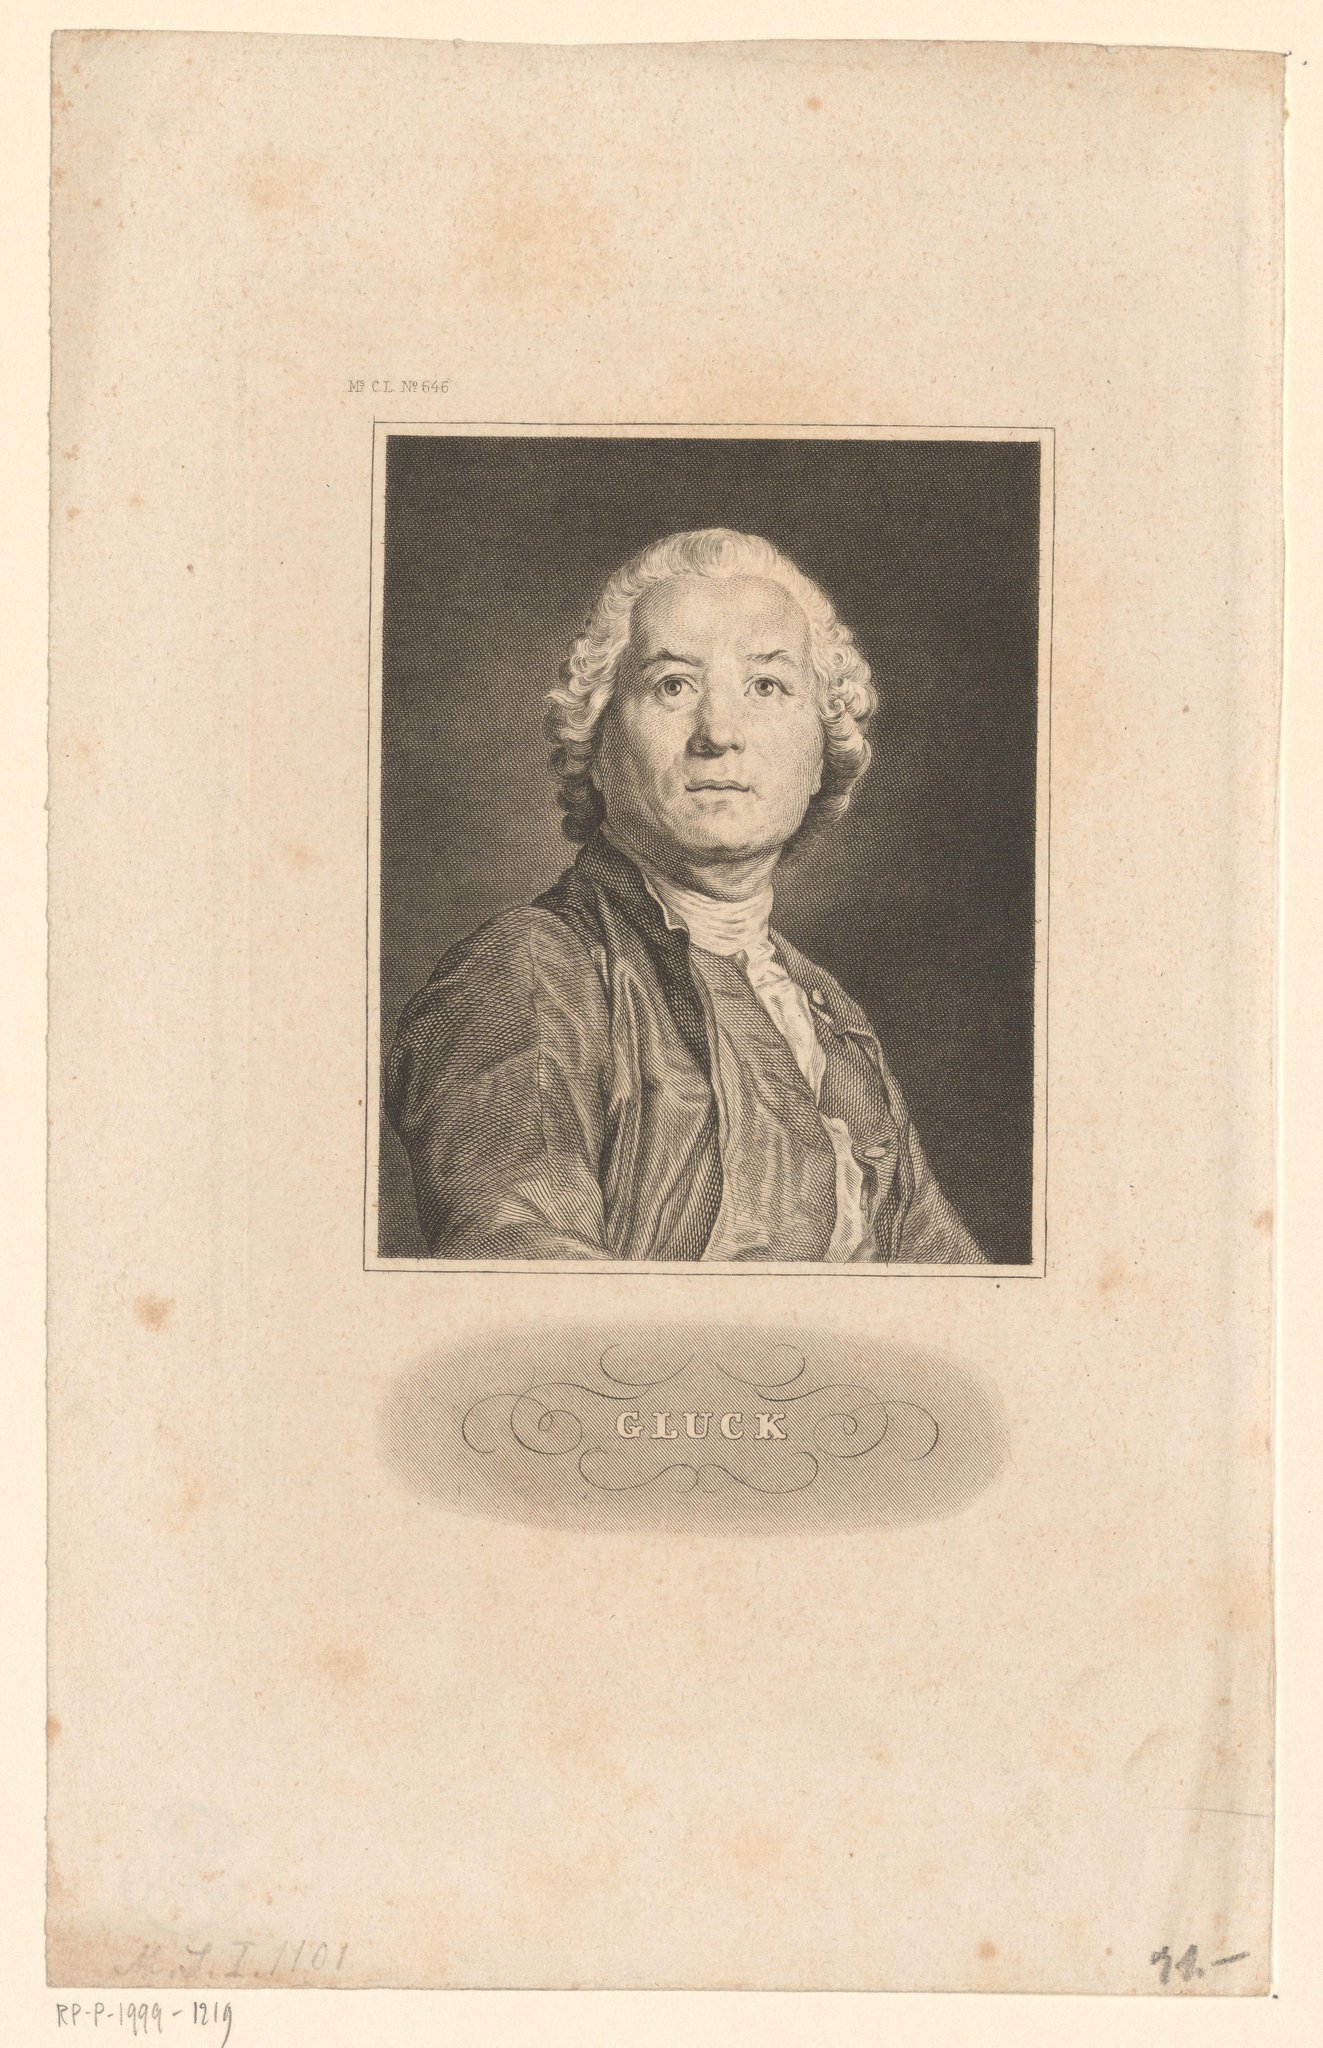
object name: print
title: Portret van Christoph Willibald von Gluck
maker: Anonymous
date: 1840-1855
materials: paper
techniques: engraving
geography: hildburghausen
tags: vienna, christoph willibald von gluck, historical persons, portrait of composer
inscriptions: collector's mark: Lugt 2760, collector's mark: Lugt 2228, collector's mark: 168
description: Prent uit: Meyer, Joseph. Das Grosse Conversations-Lexikon für die gebildeten Stände. Hildburghausen: Bibliographisches Institut, [1828-1855].